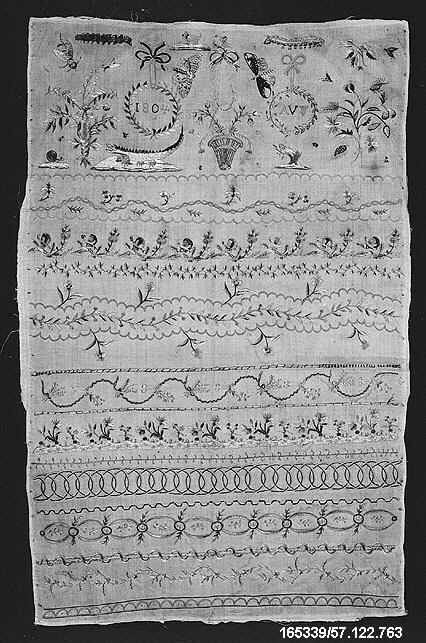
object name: sampler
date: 1804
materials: linen, silk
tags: butterflies,flowers